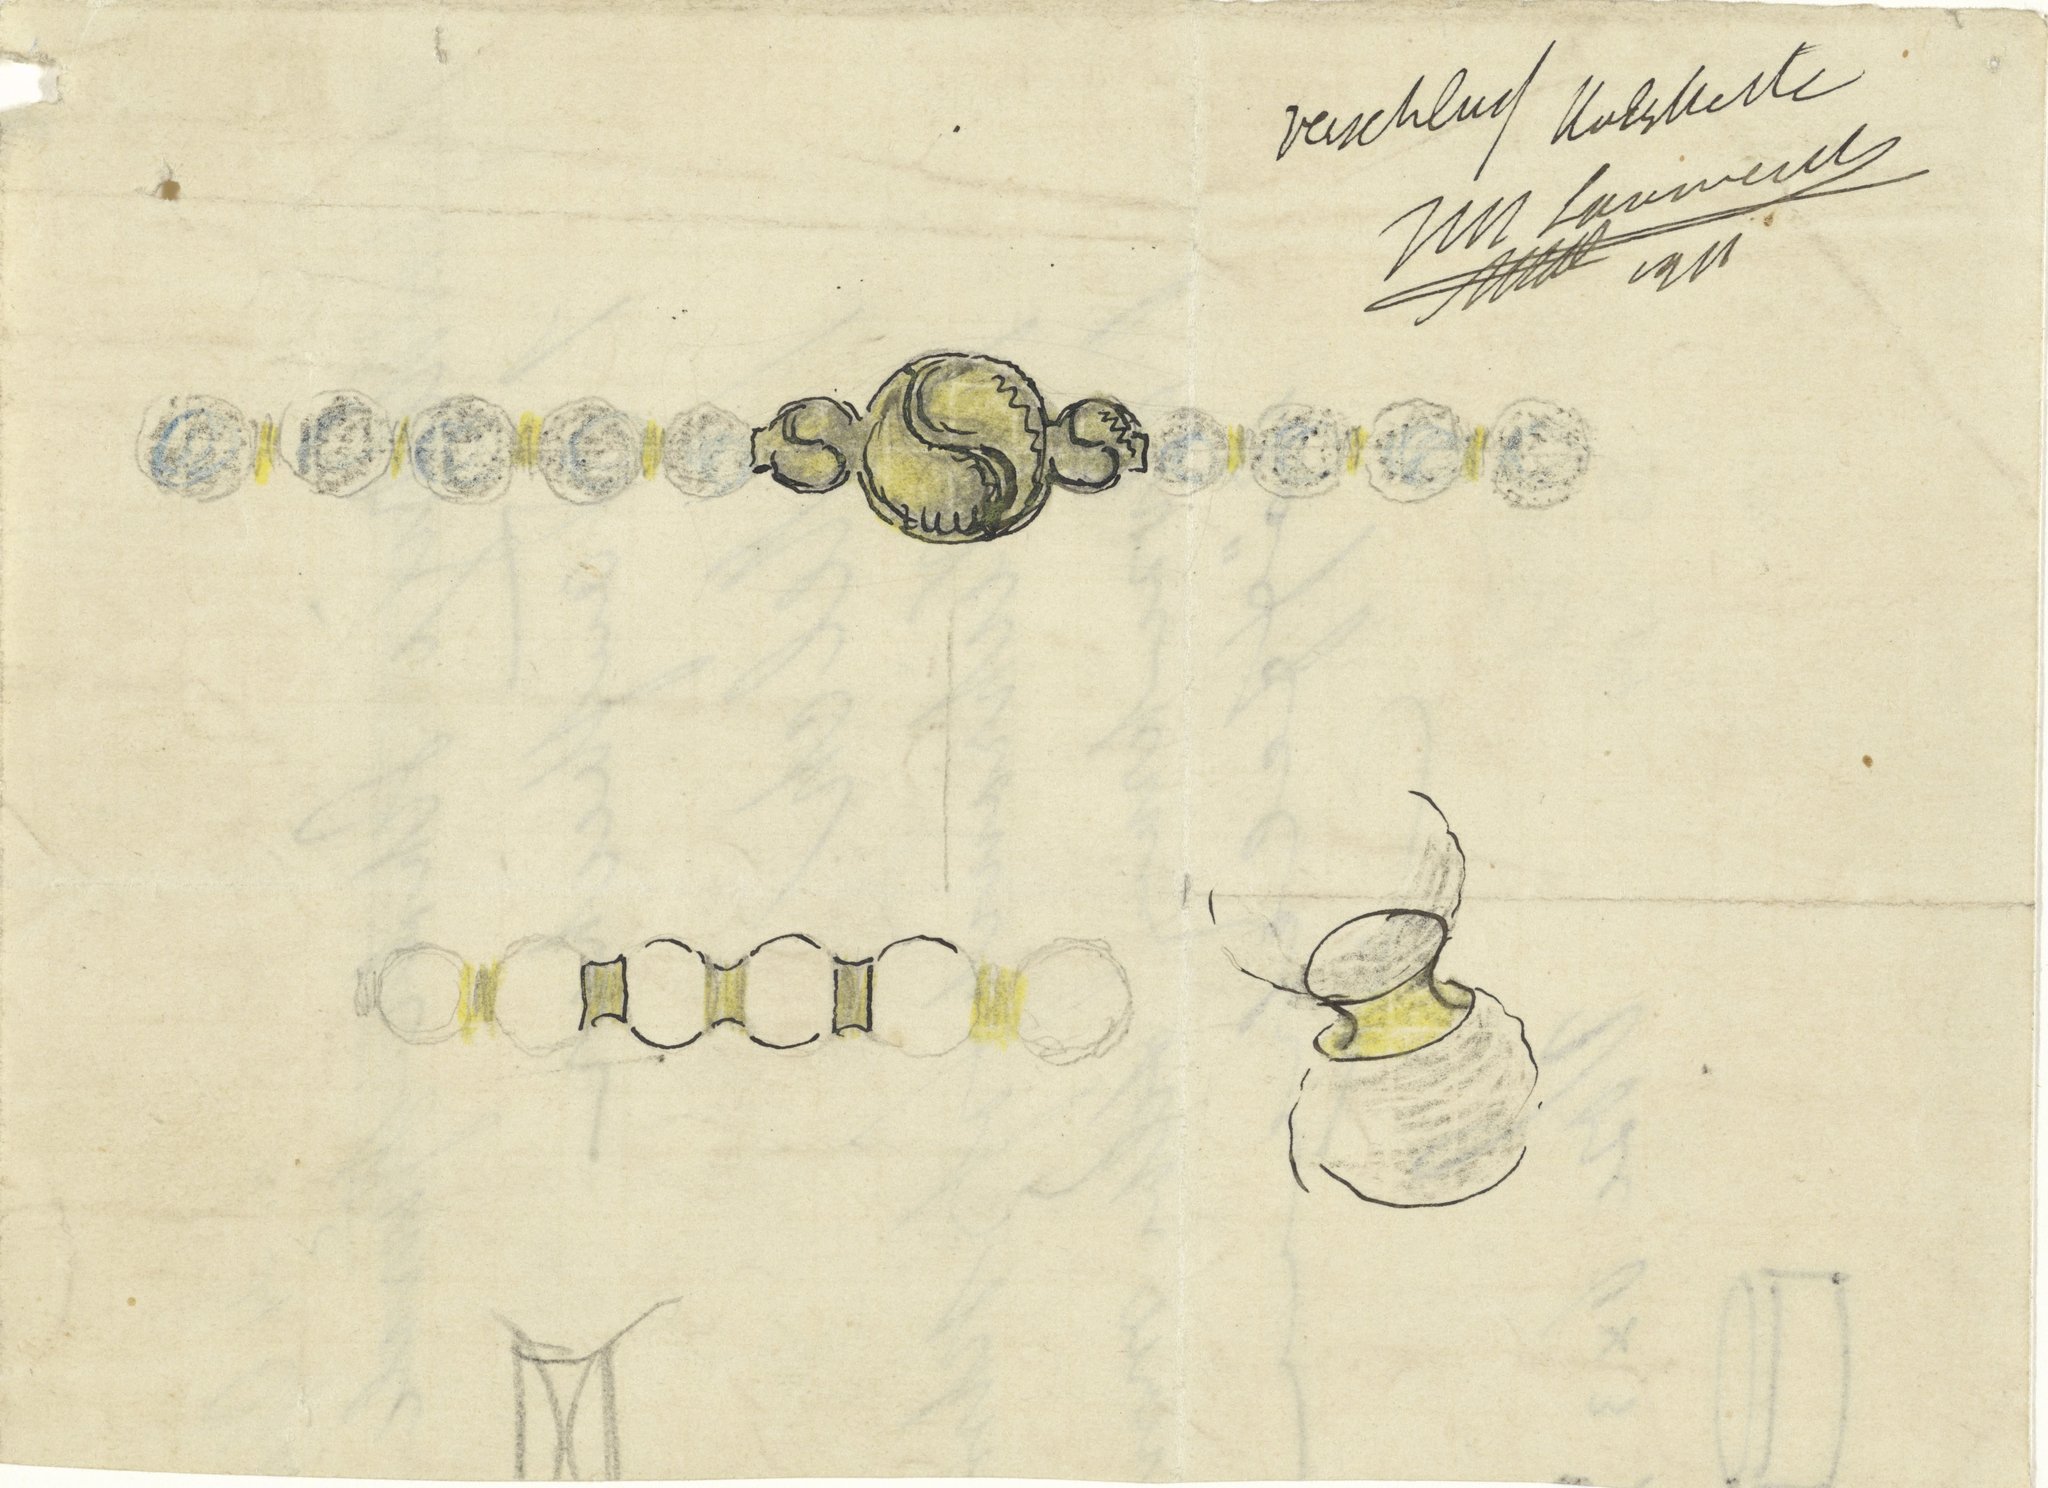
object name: design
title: Ontwerp voor schakels en sluiting van een halsketting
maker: mathieu lauweriks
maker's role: designer, draughtsman, print maker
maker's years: 1864-1932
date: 1911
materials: ink, pencil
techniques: pen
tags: necklace